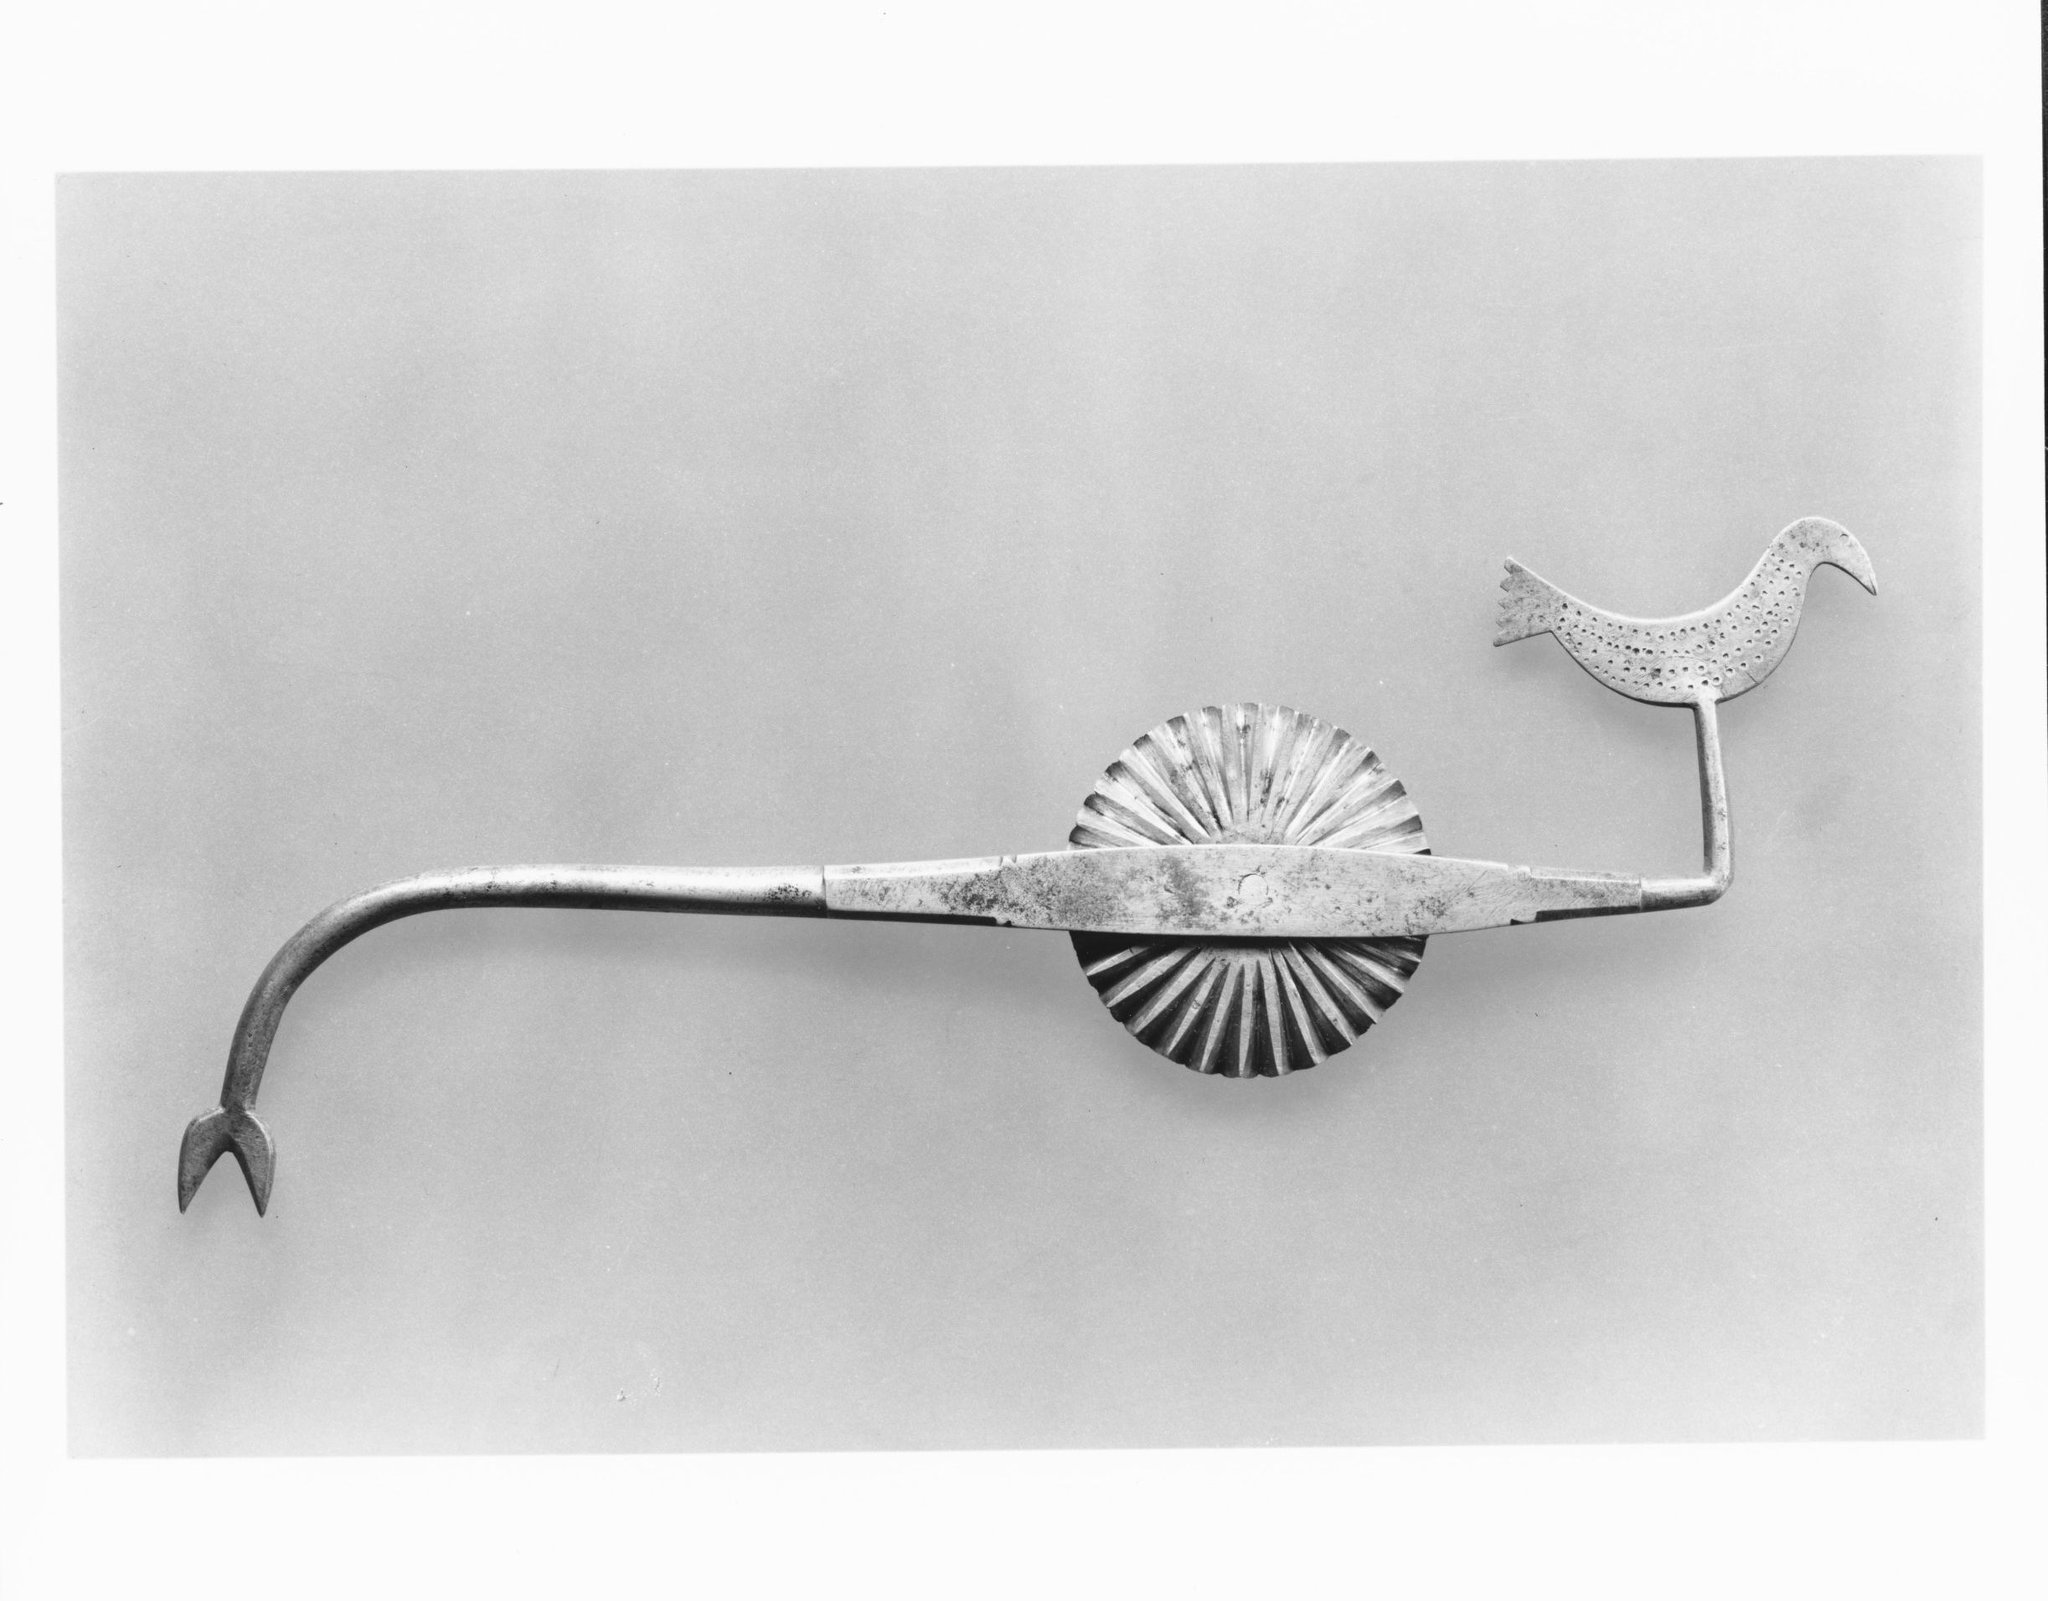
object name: jagging wheel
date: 1800-1900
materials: steel